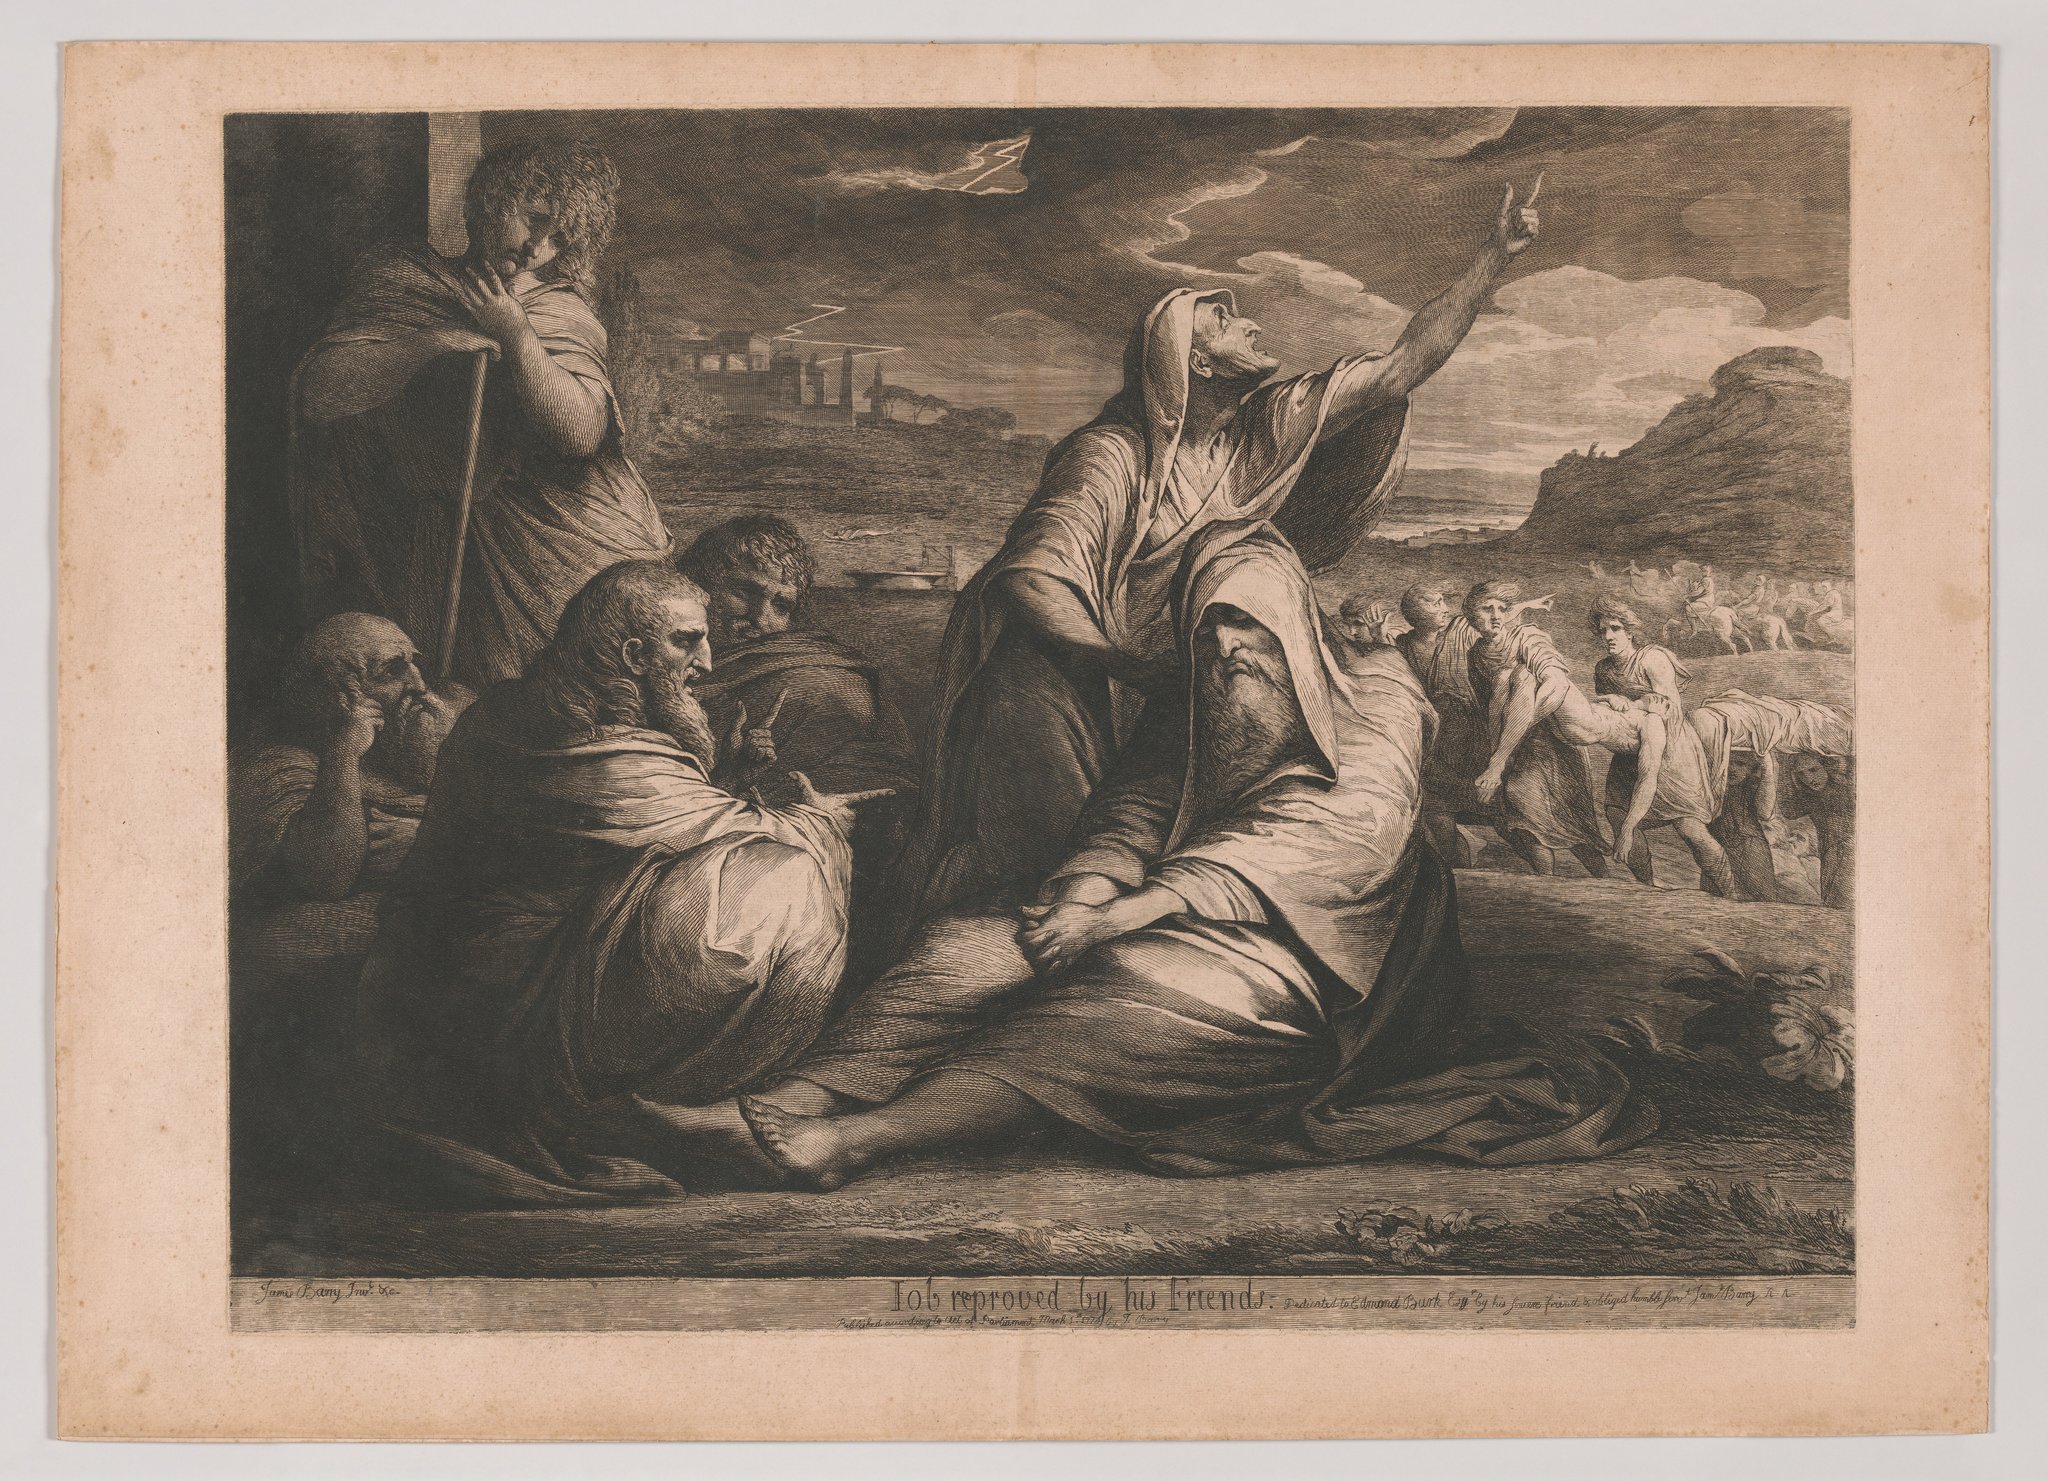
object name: print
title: Job Reproved by His Friends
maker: james barry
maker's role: artist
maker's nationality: irish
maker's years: 1741-1806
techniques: aquatint, etching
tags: men,women